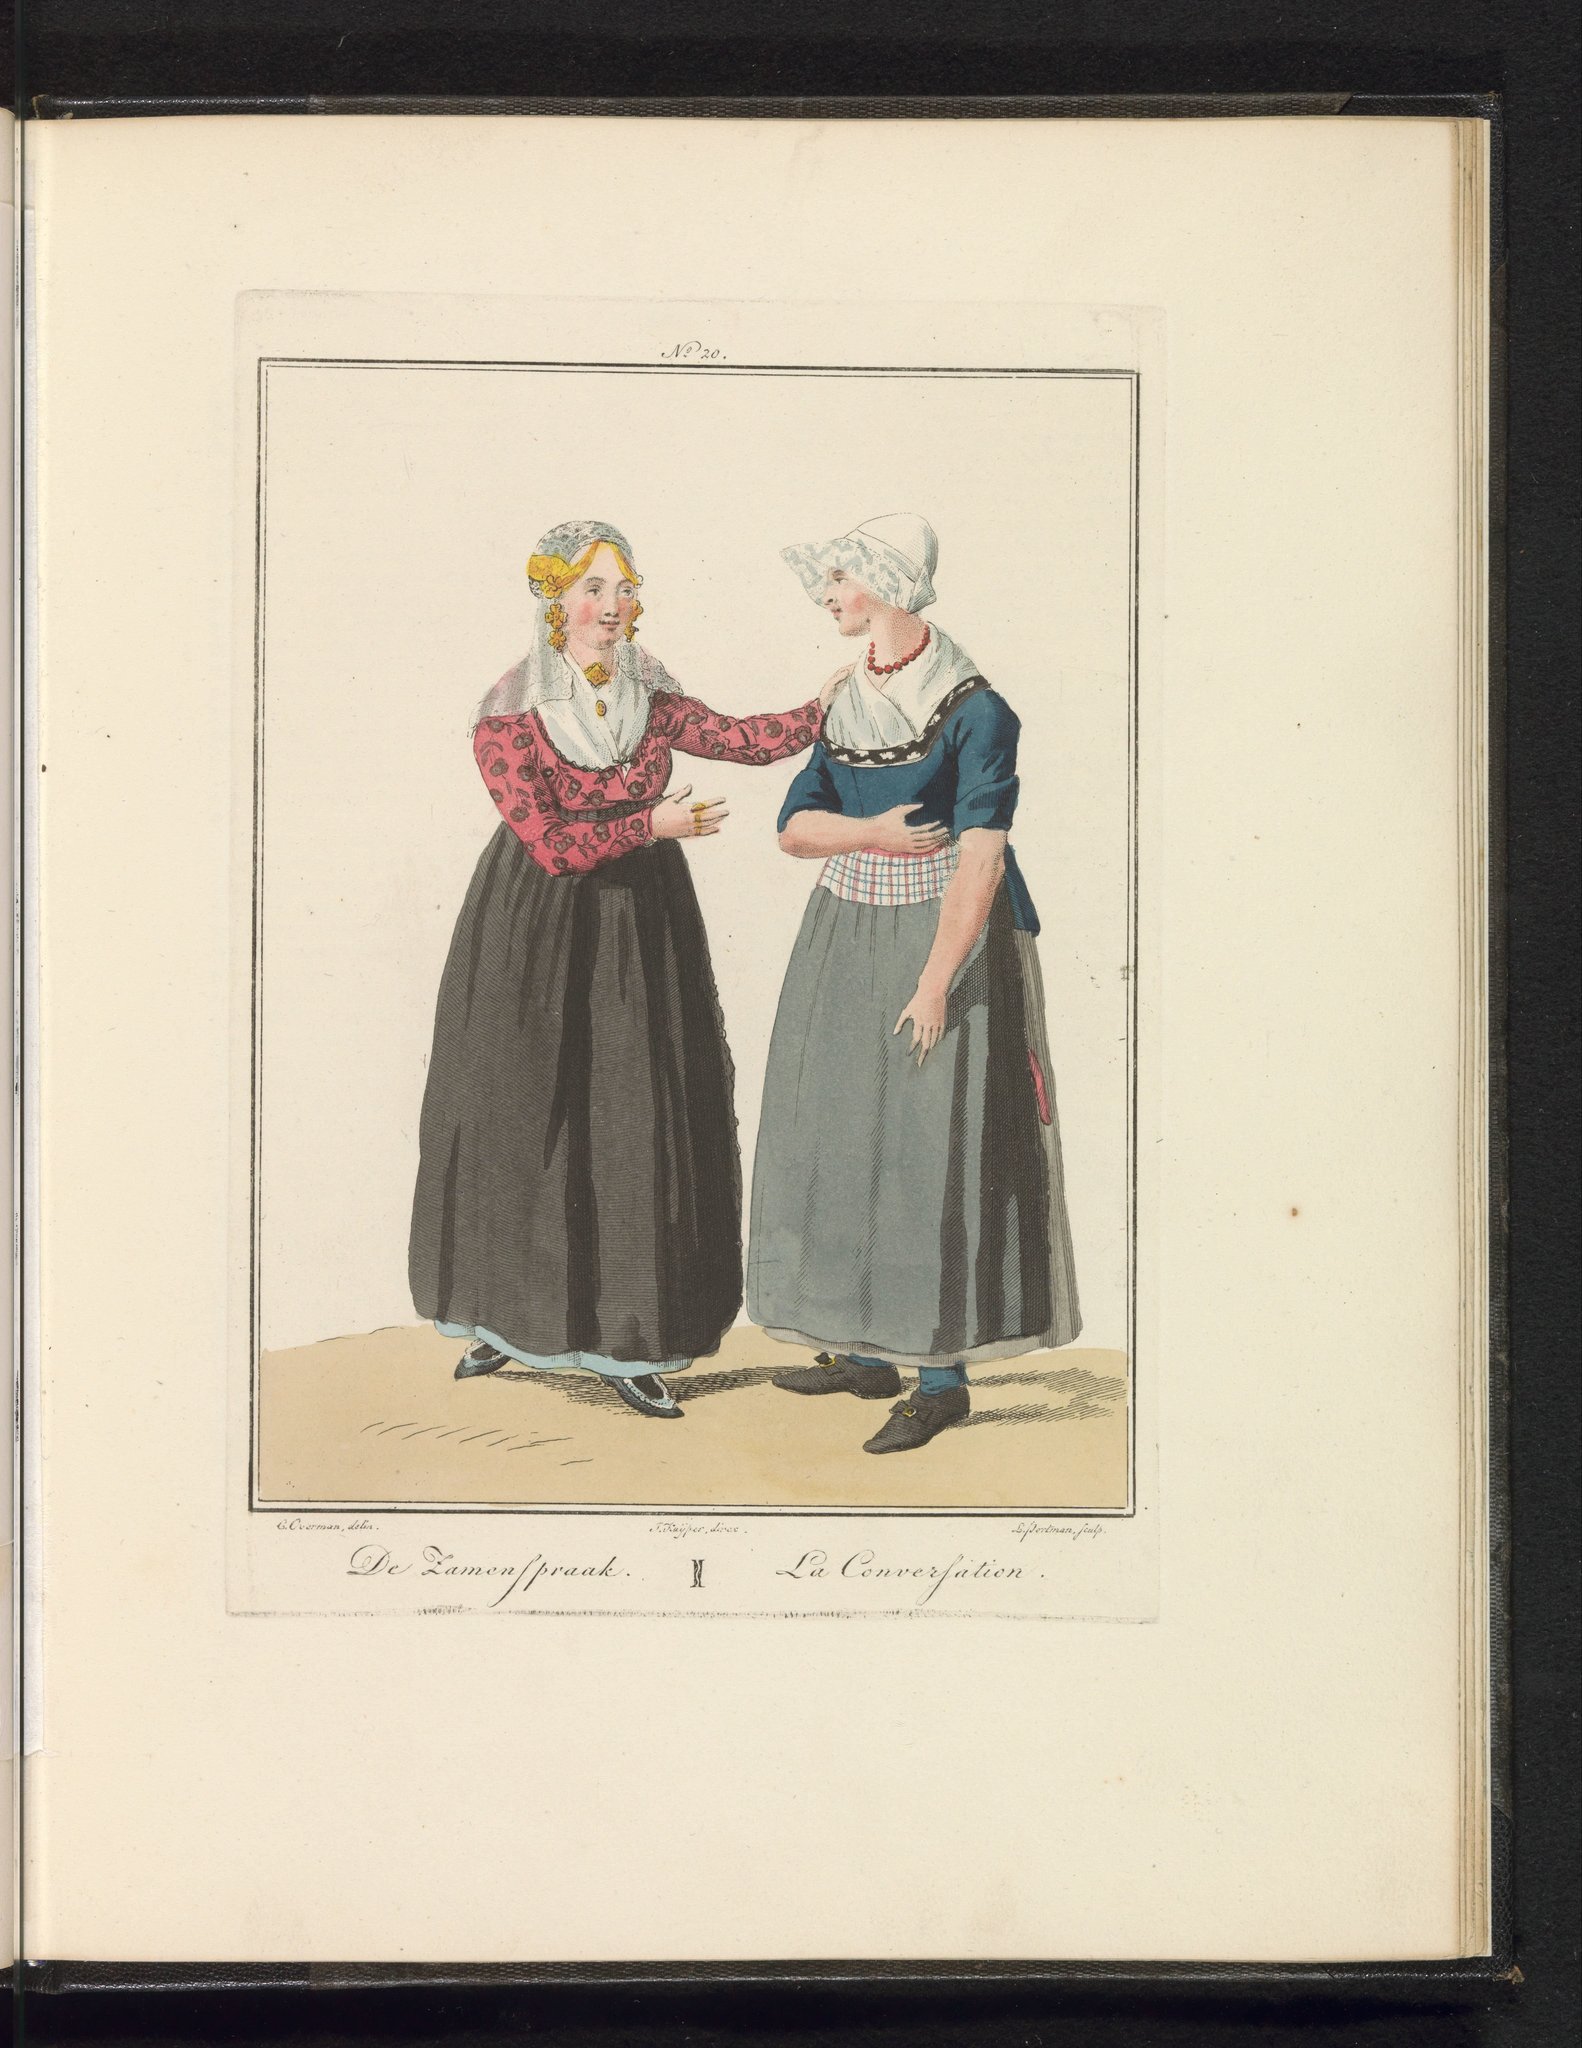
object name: costume print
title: De Zamenspraak / La Conversation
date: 1807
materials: paper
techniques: etching, hand coloring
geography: amsterdam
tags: folk costume, regional costume, clothes, costume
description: Gebruikt als illustratie in: Evert Maaskamp, Afbeeldingen van de kleedingen, zeden en gewoonten in de noordelijke provincien van het Koningrijk der Nederlanden, met den aanvang der negentiende eeuw = Tableaux des habillemens, mœurs et coutumes dans les provinces septentrionales du Royaume des Pays-Bas, au commencement du dix-neuvième siècle. Amsterdam: Evert Maaskamp, 1829 [heruitgave van de oorspronkelijke platen eerst verschenen in 1803-1807].